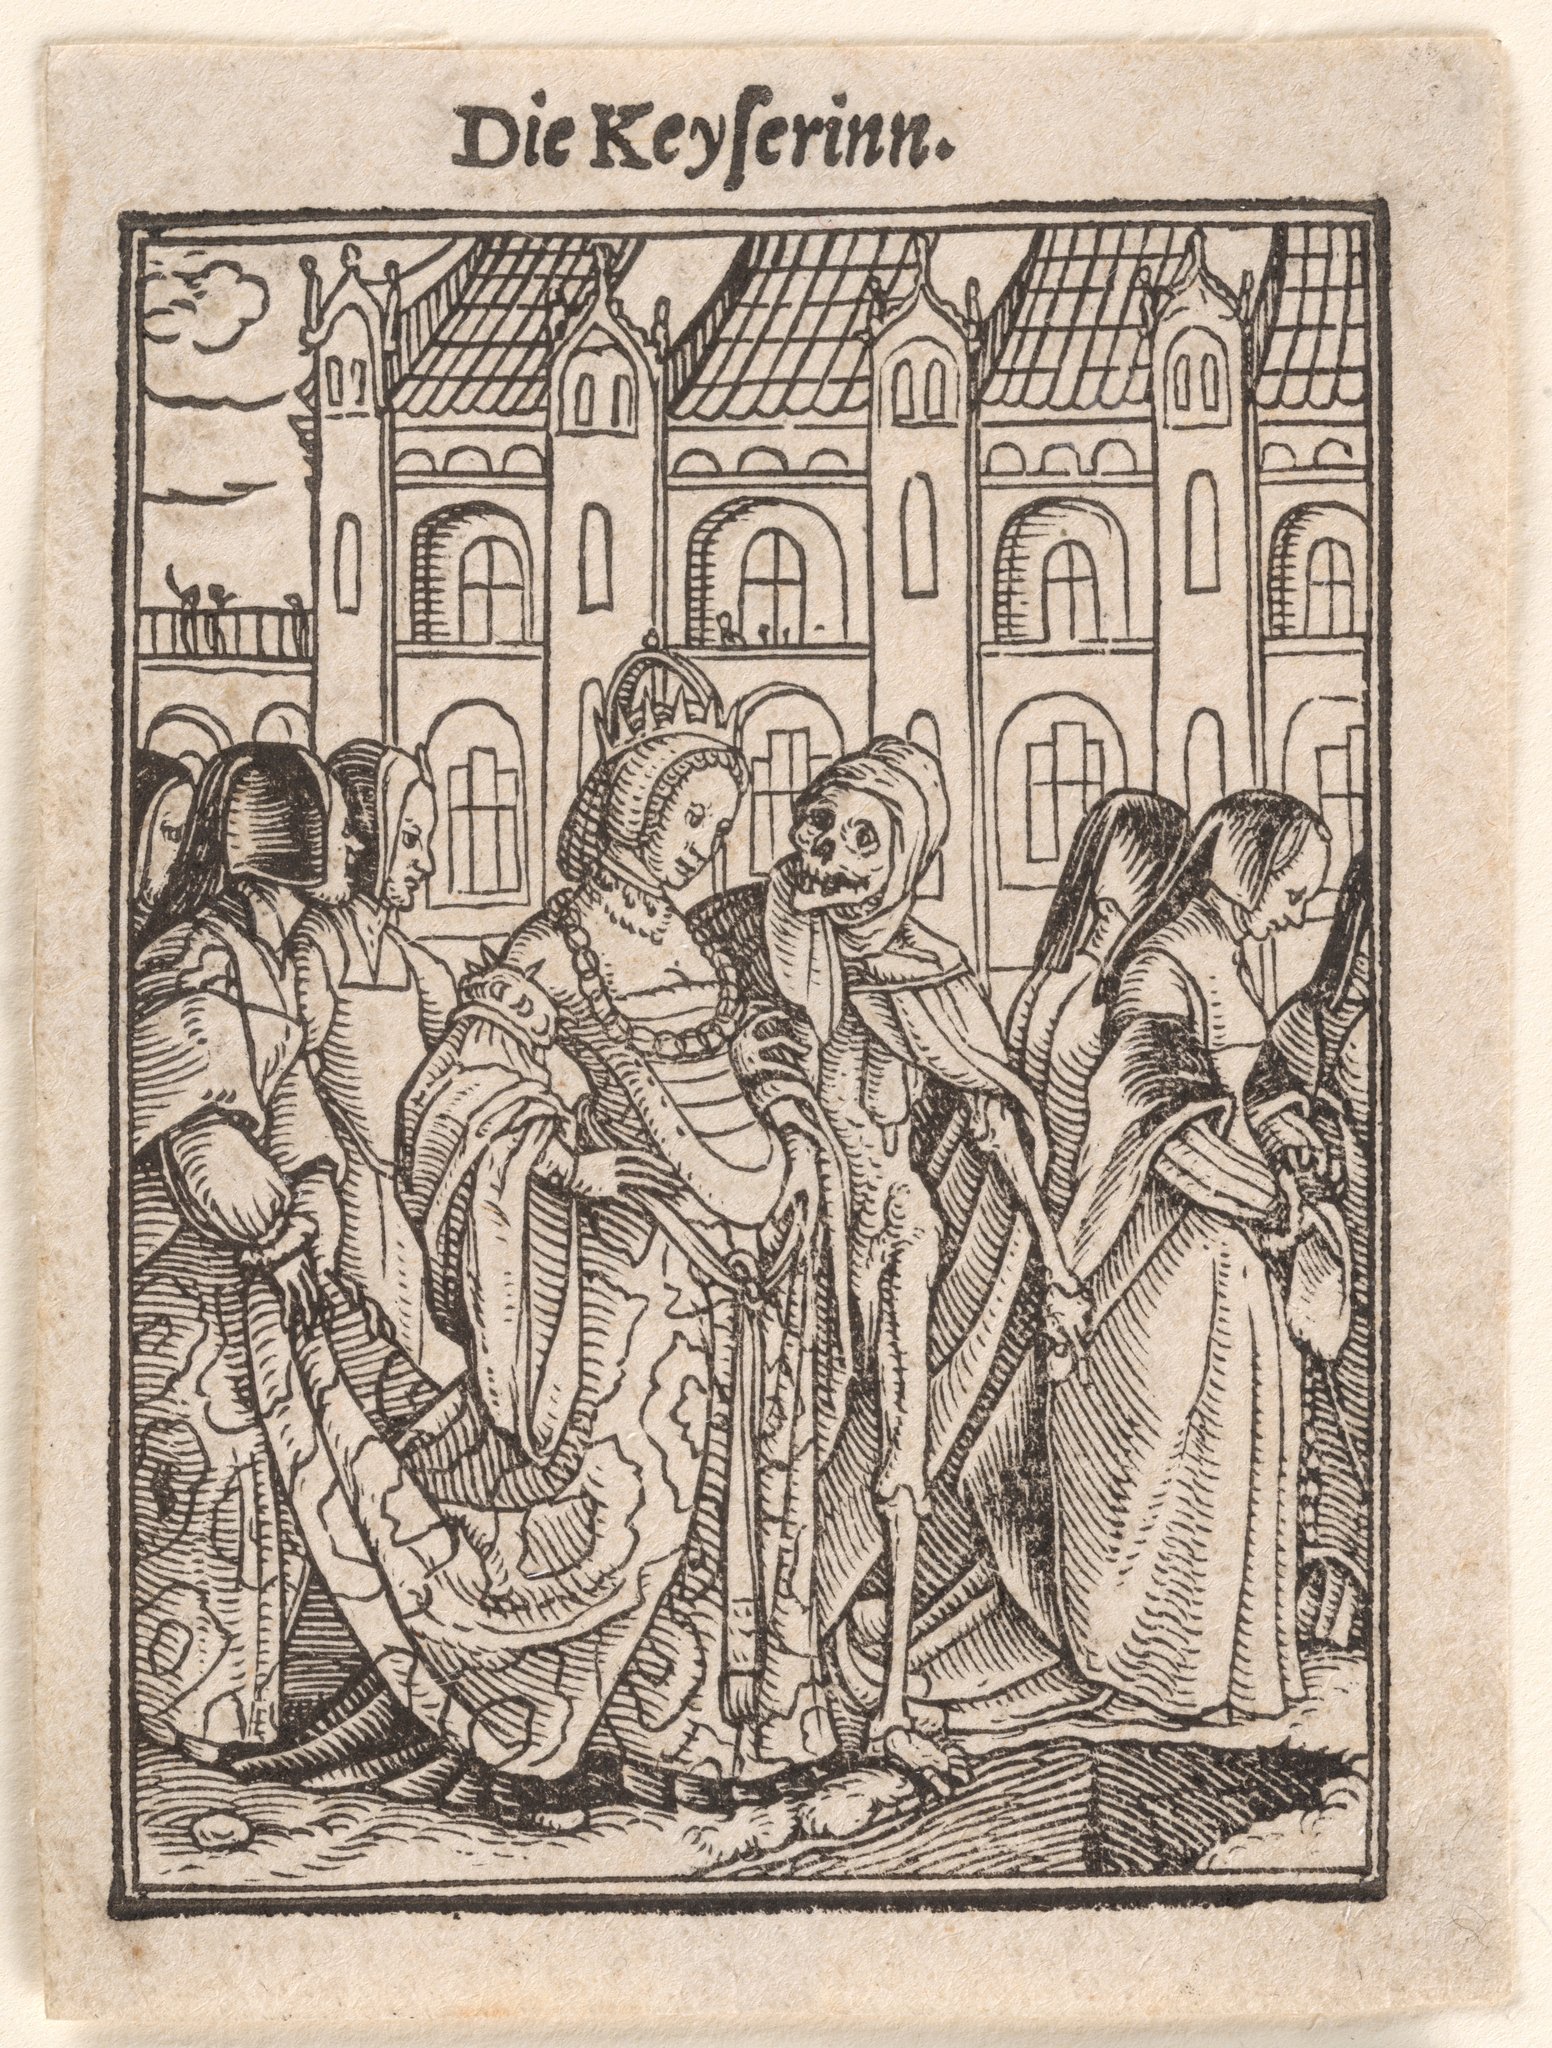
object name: print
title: The Empress, from "The Dance of Death"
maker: hans holbein the younger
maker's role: artist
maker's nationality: german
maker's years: 1497-1543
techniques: woodcut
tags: skeletons,women